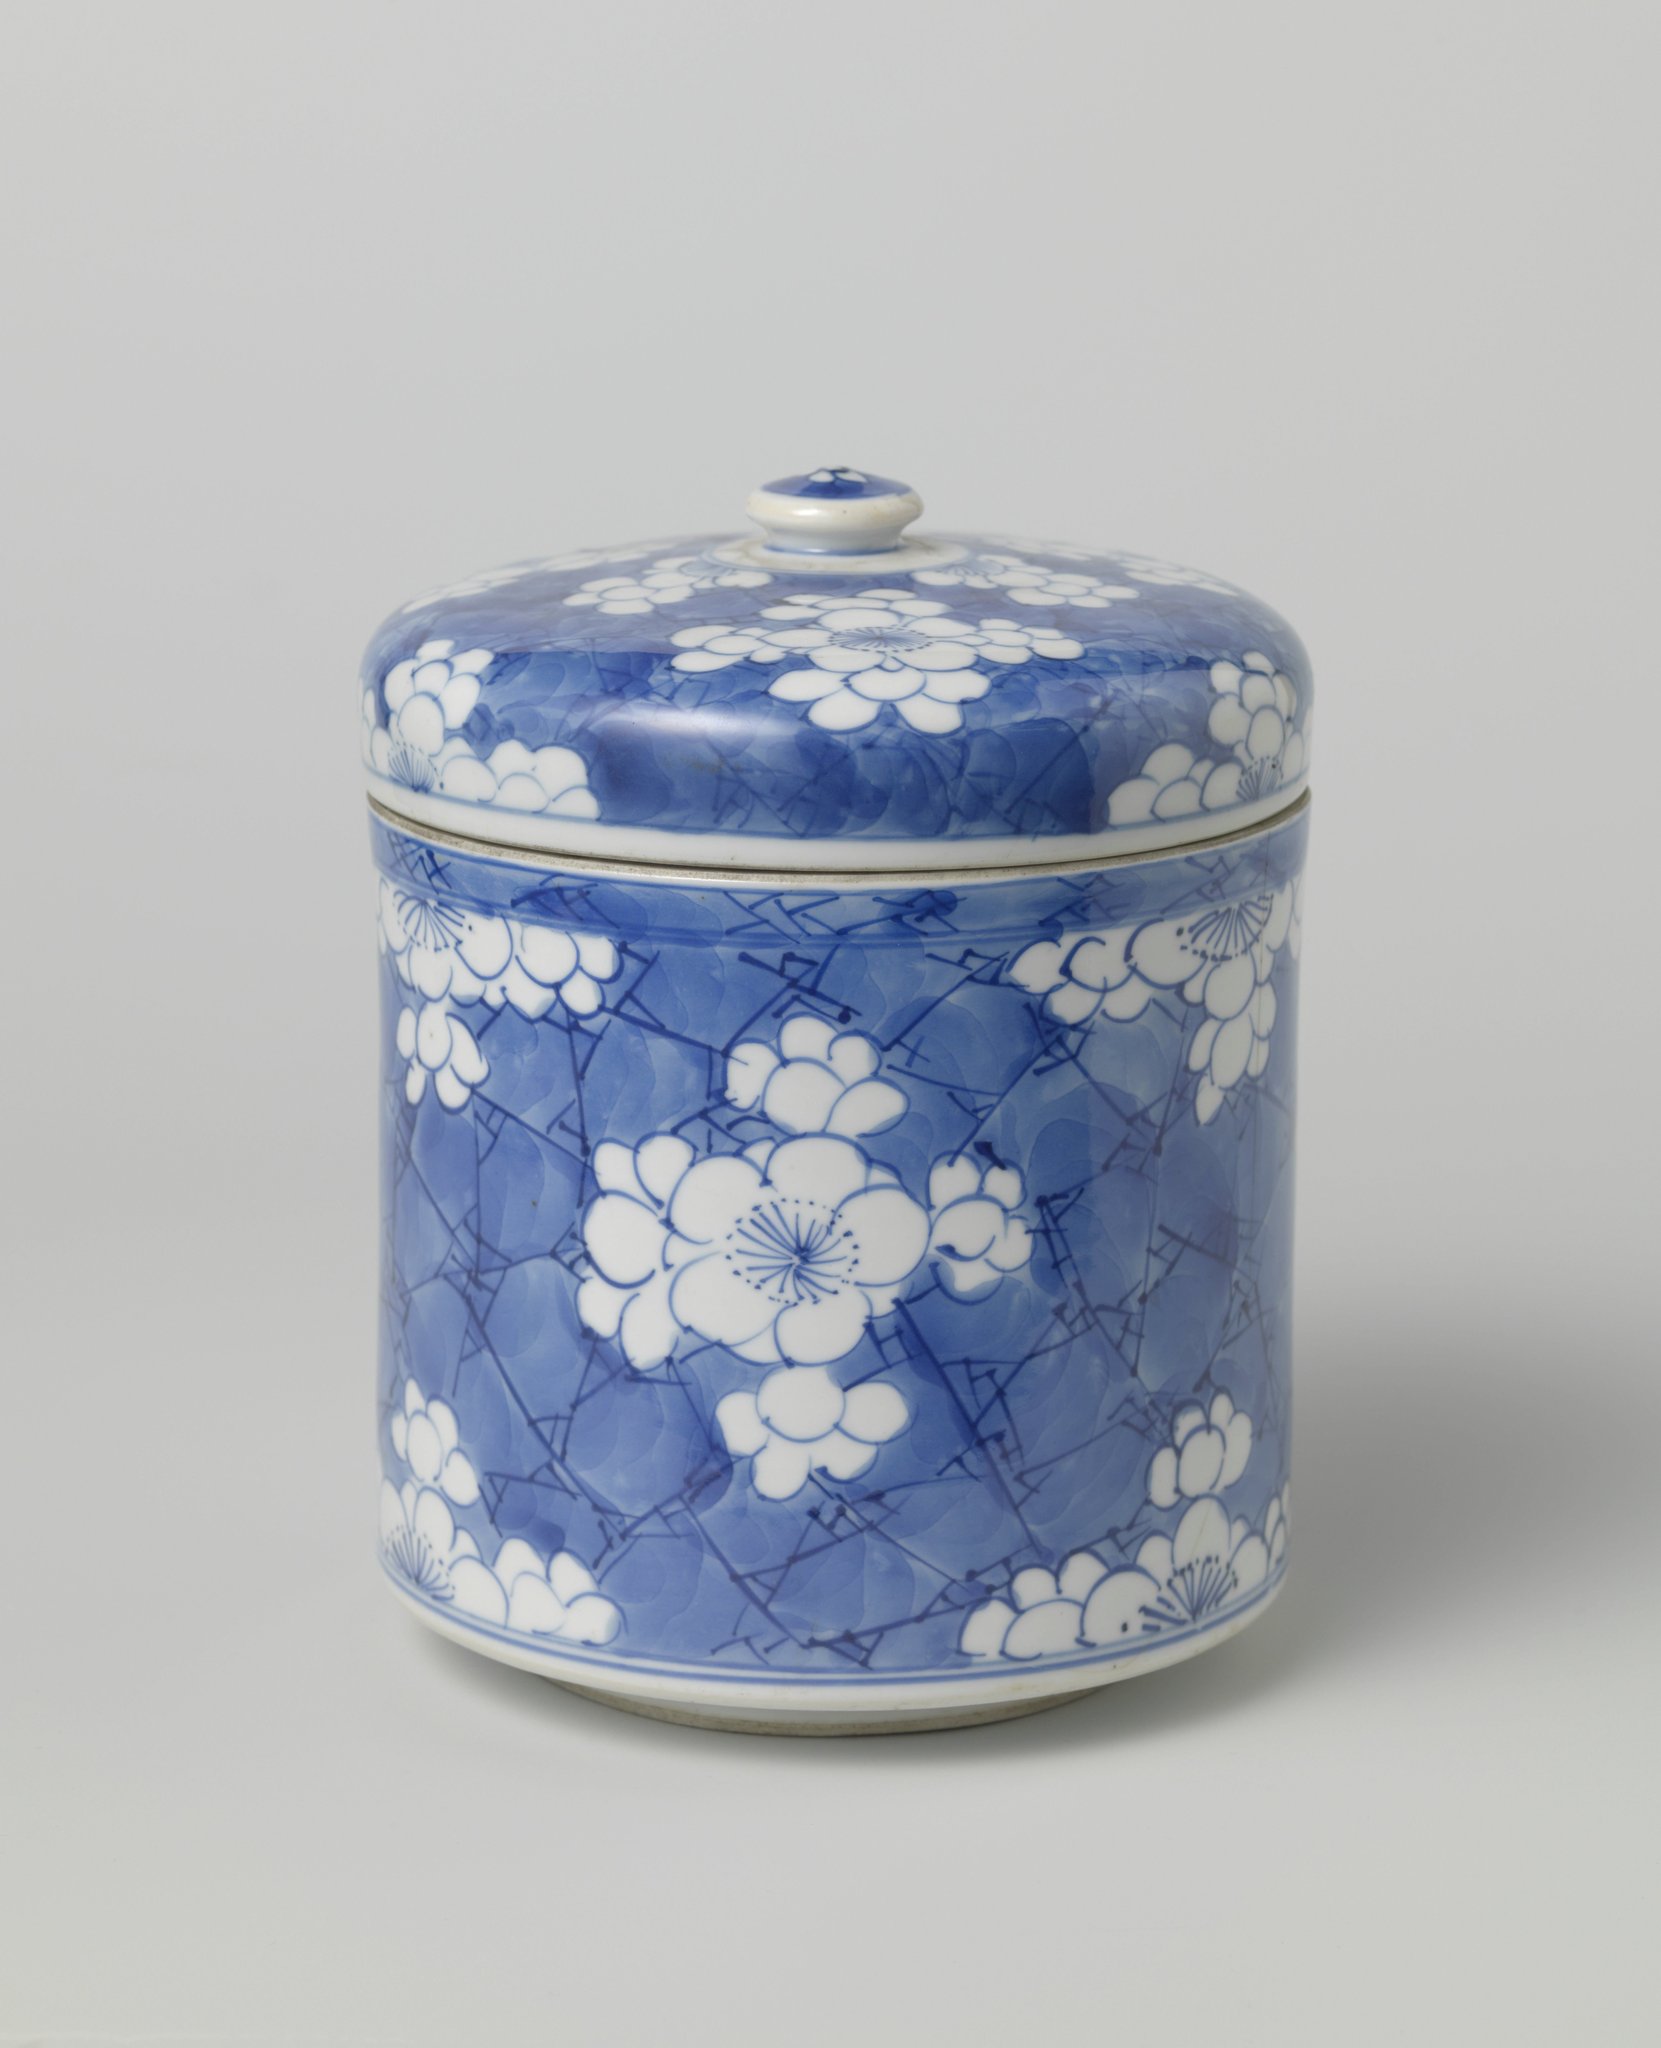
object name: covered jar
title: Cylindrical covered jar with flower-heads in reserve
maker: Anonymous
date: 1680-1720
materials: cobalt, glaze, paint, porcelain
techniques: firing, turning, vitrification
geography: china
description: Cilindrische dekselpot van porselein, beschilderd in onderglazuur blauw. De pot en deksel zijn bedekt met een 'crackled ice' blauwe grond met pruimenbloesems in reserve; de platte dekselknop met bloem tegen een blauwe grond. Een barst in de wand. Blauw-wit.